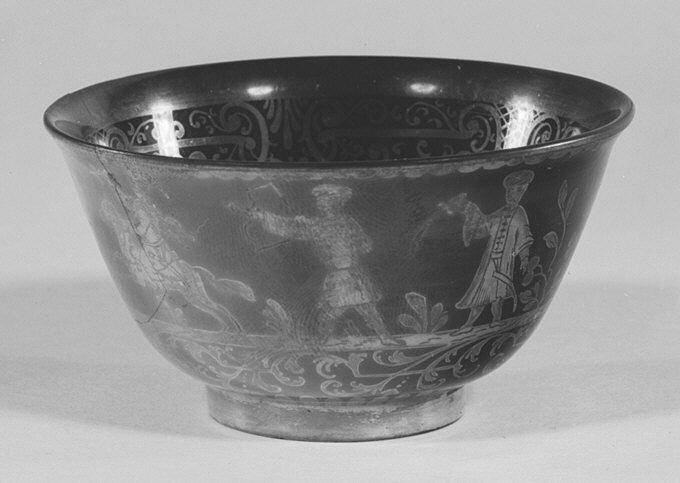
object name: tea bowl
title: Tea bowls (set of six) (part of a set)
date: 1726-1750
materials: earthenware, silver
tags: human figures,horses